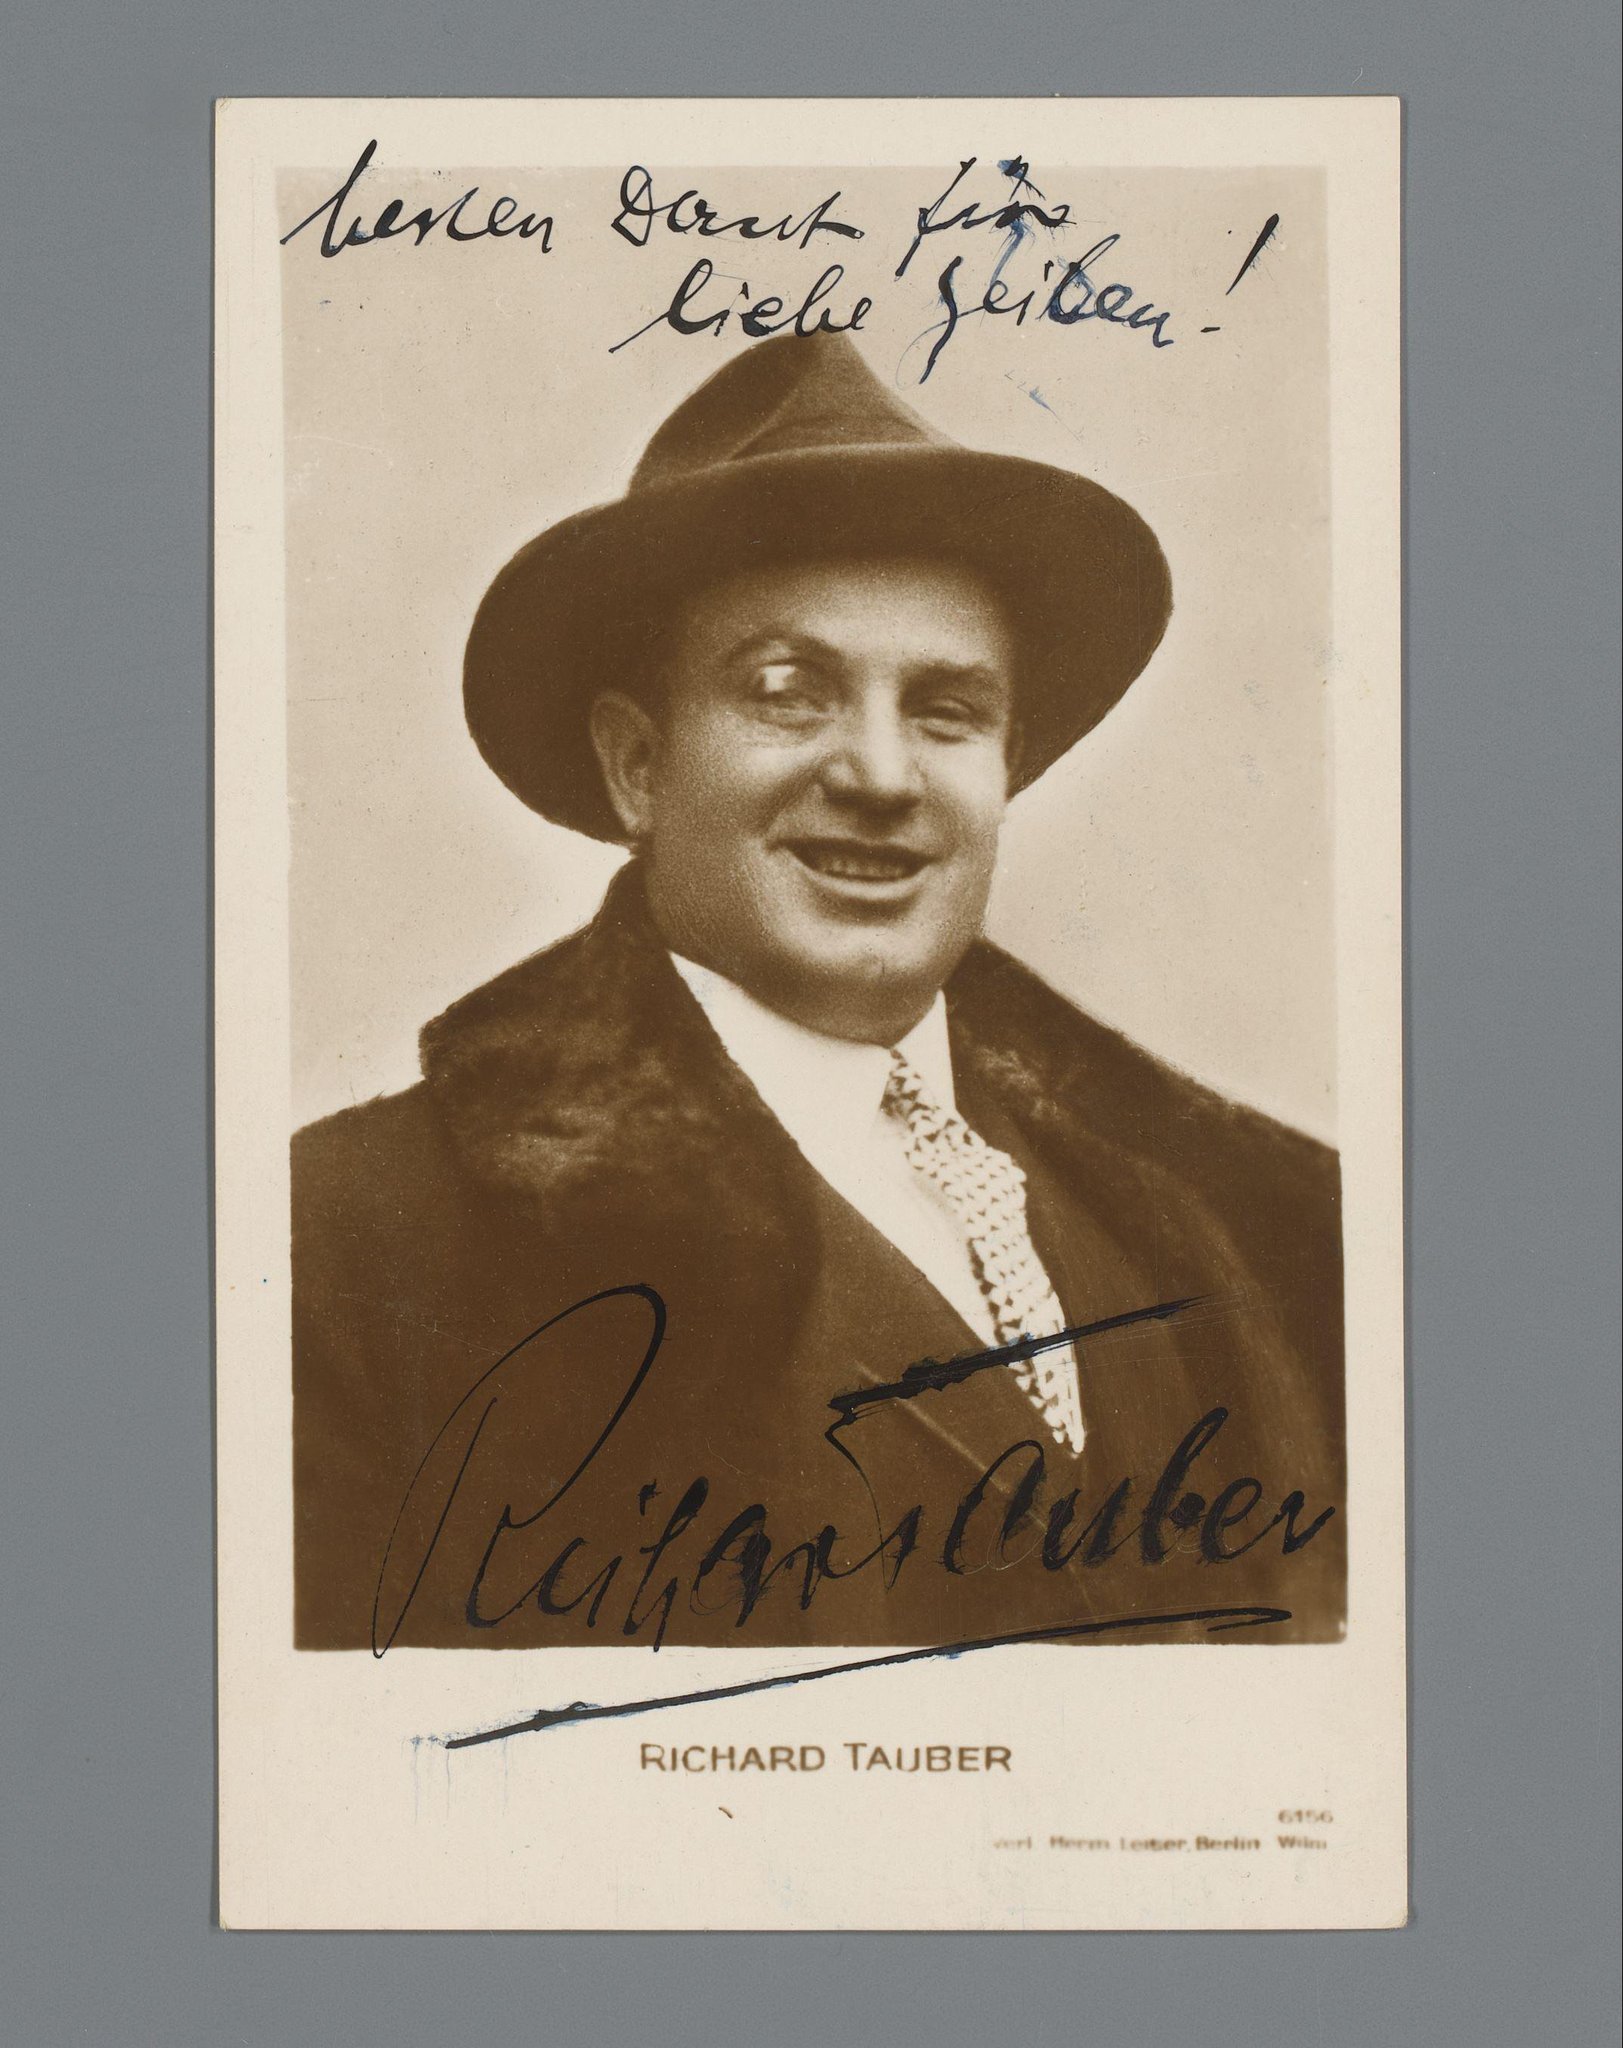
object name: photograph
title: Portret van de tenor Richard Tauber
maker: Anonymous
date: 1930-1940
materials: paper, ink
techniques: gelatin silver print, pen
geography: berlin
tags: london, historical persons, portrait of opera-singer, berlin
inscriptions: inscription: ‘besten Dank für/ leibe Zeiten!/ Richard Tauber’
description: Gesigneerd en met handgeschreven opdracht.